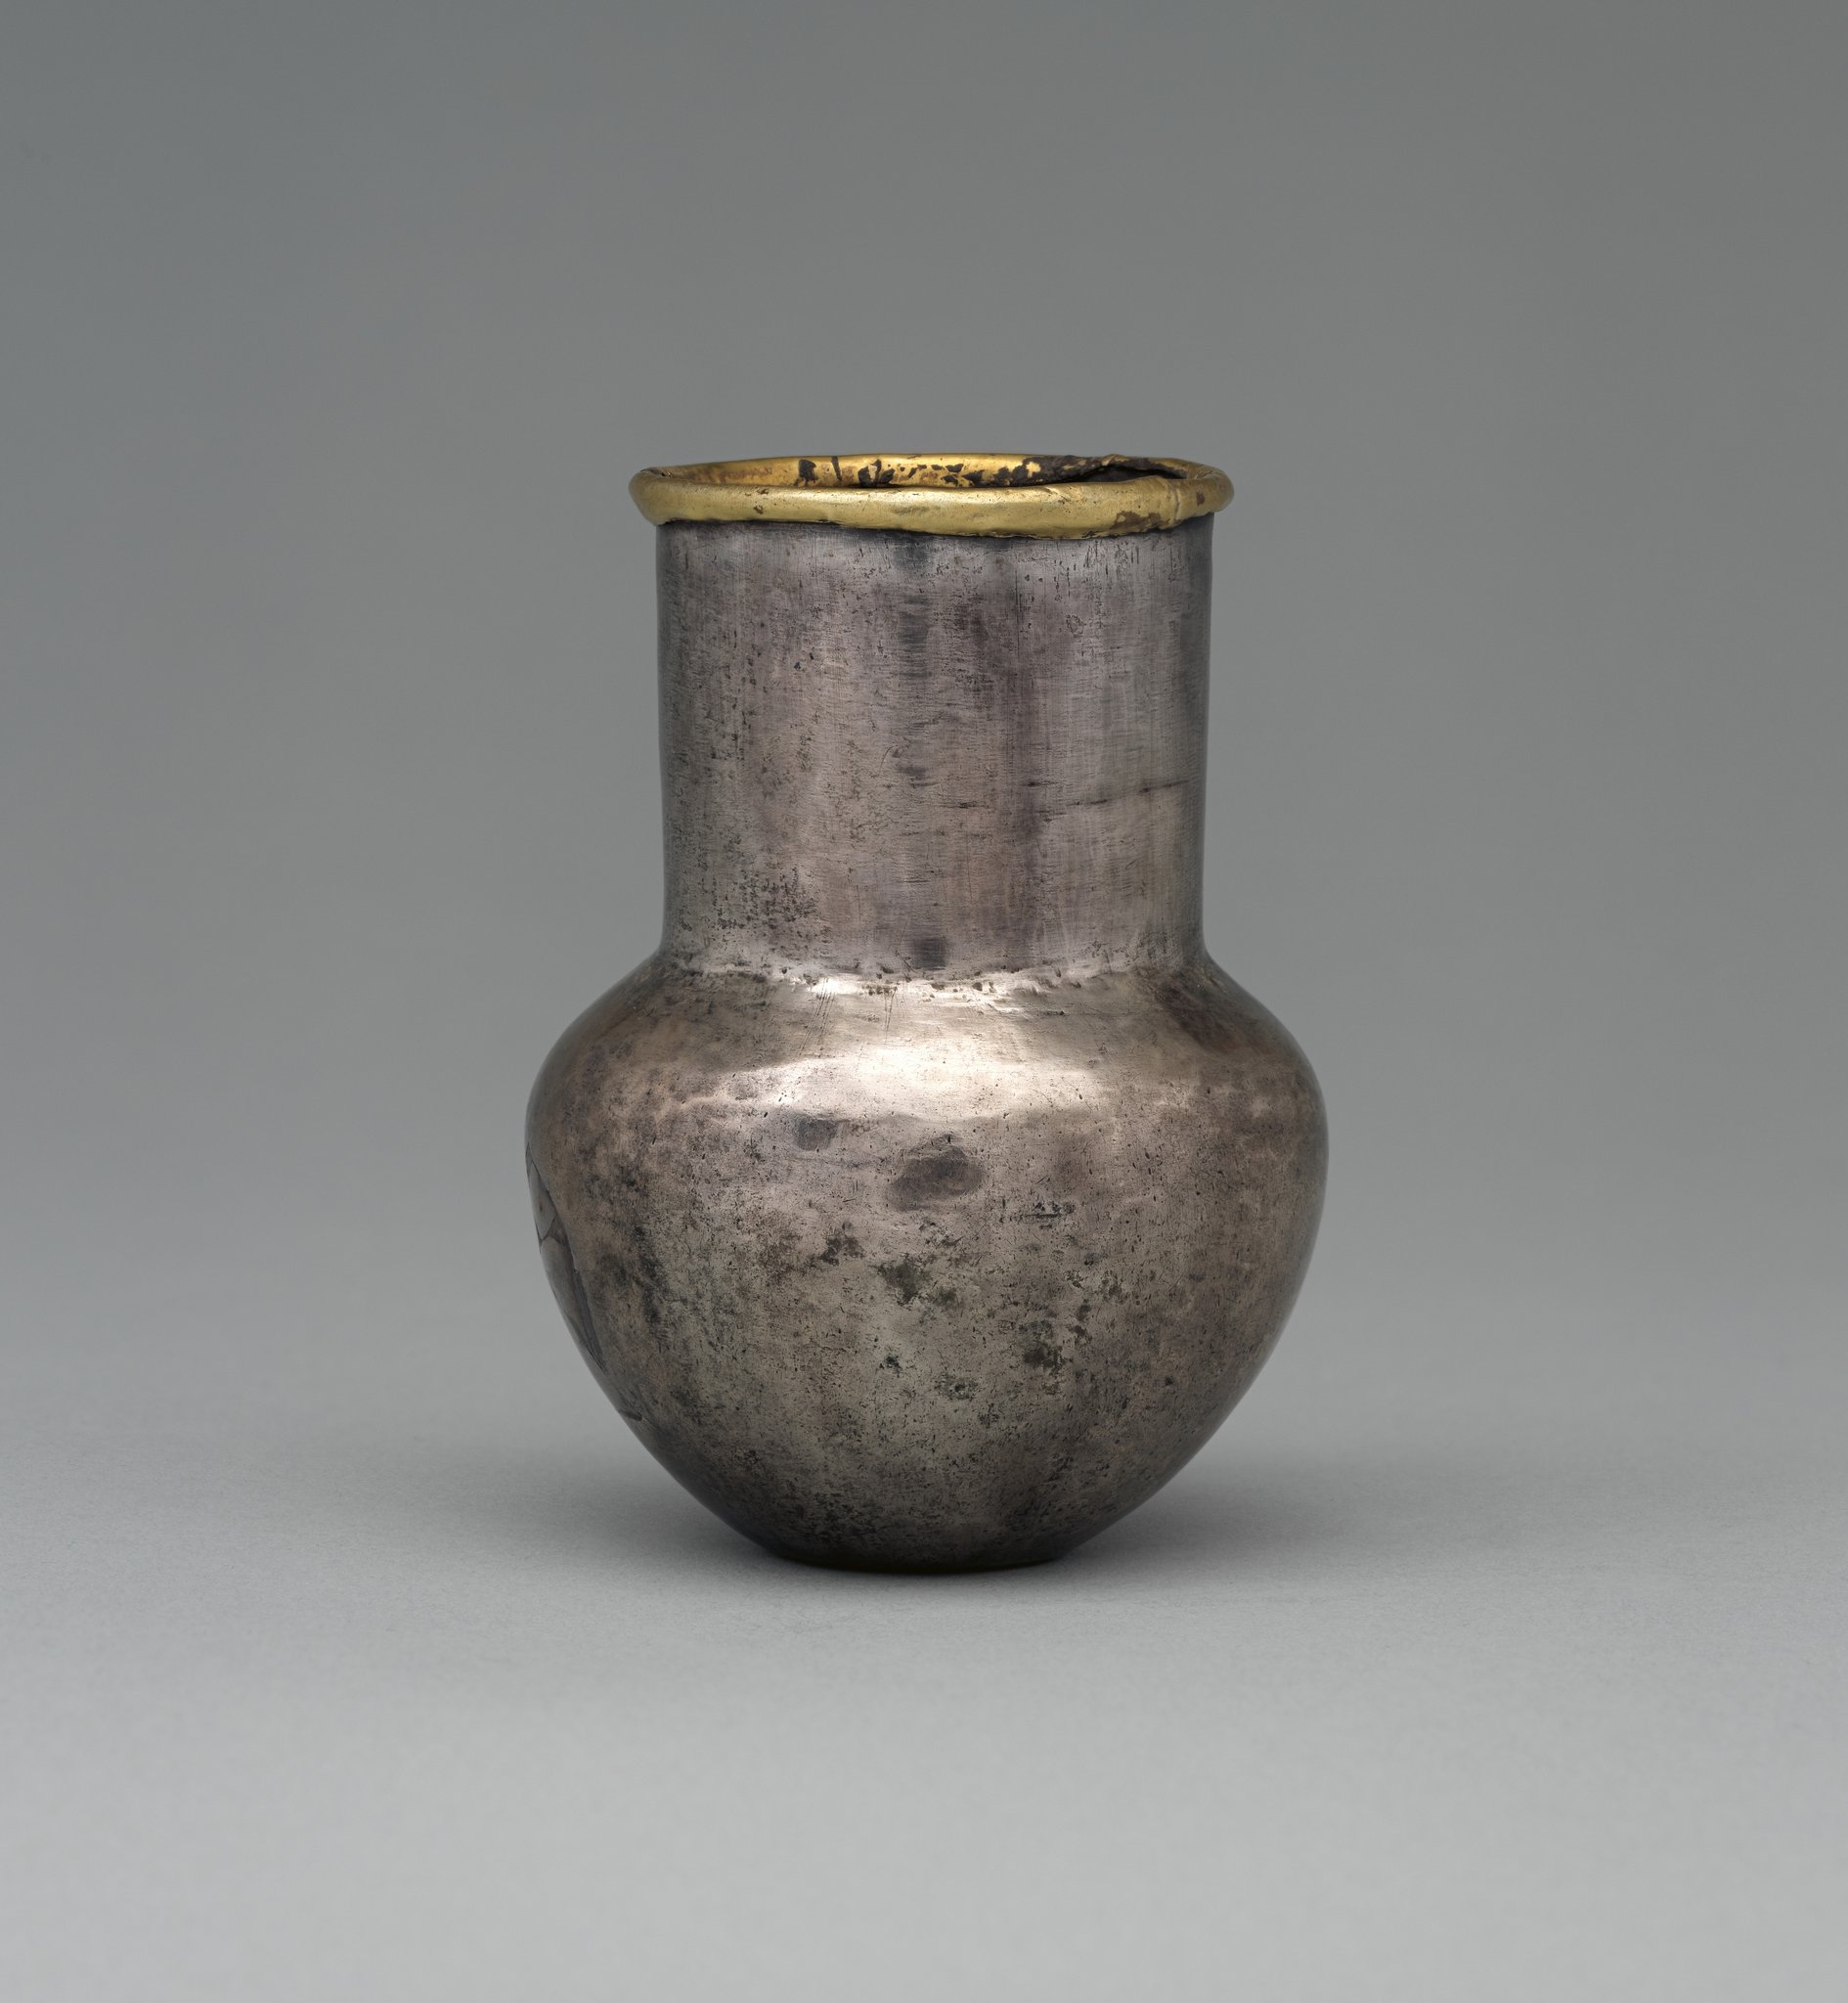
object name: jar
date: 1279-1213 BCE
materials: silver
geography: egypt